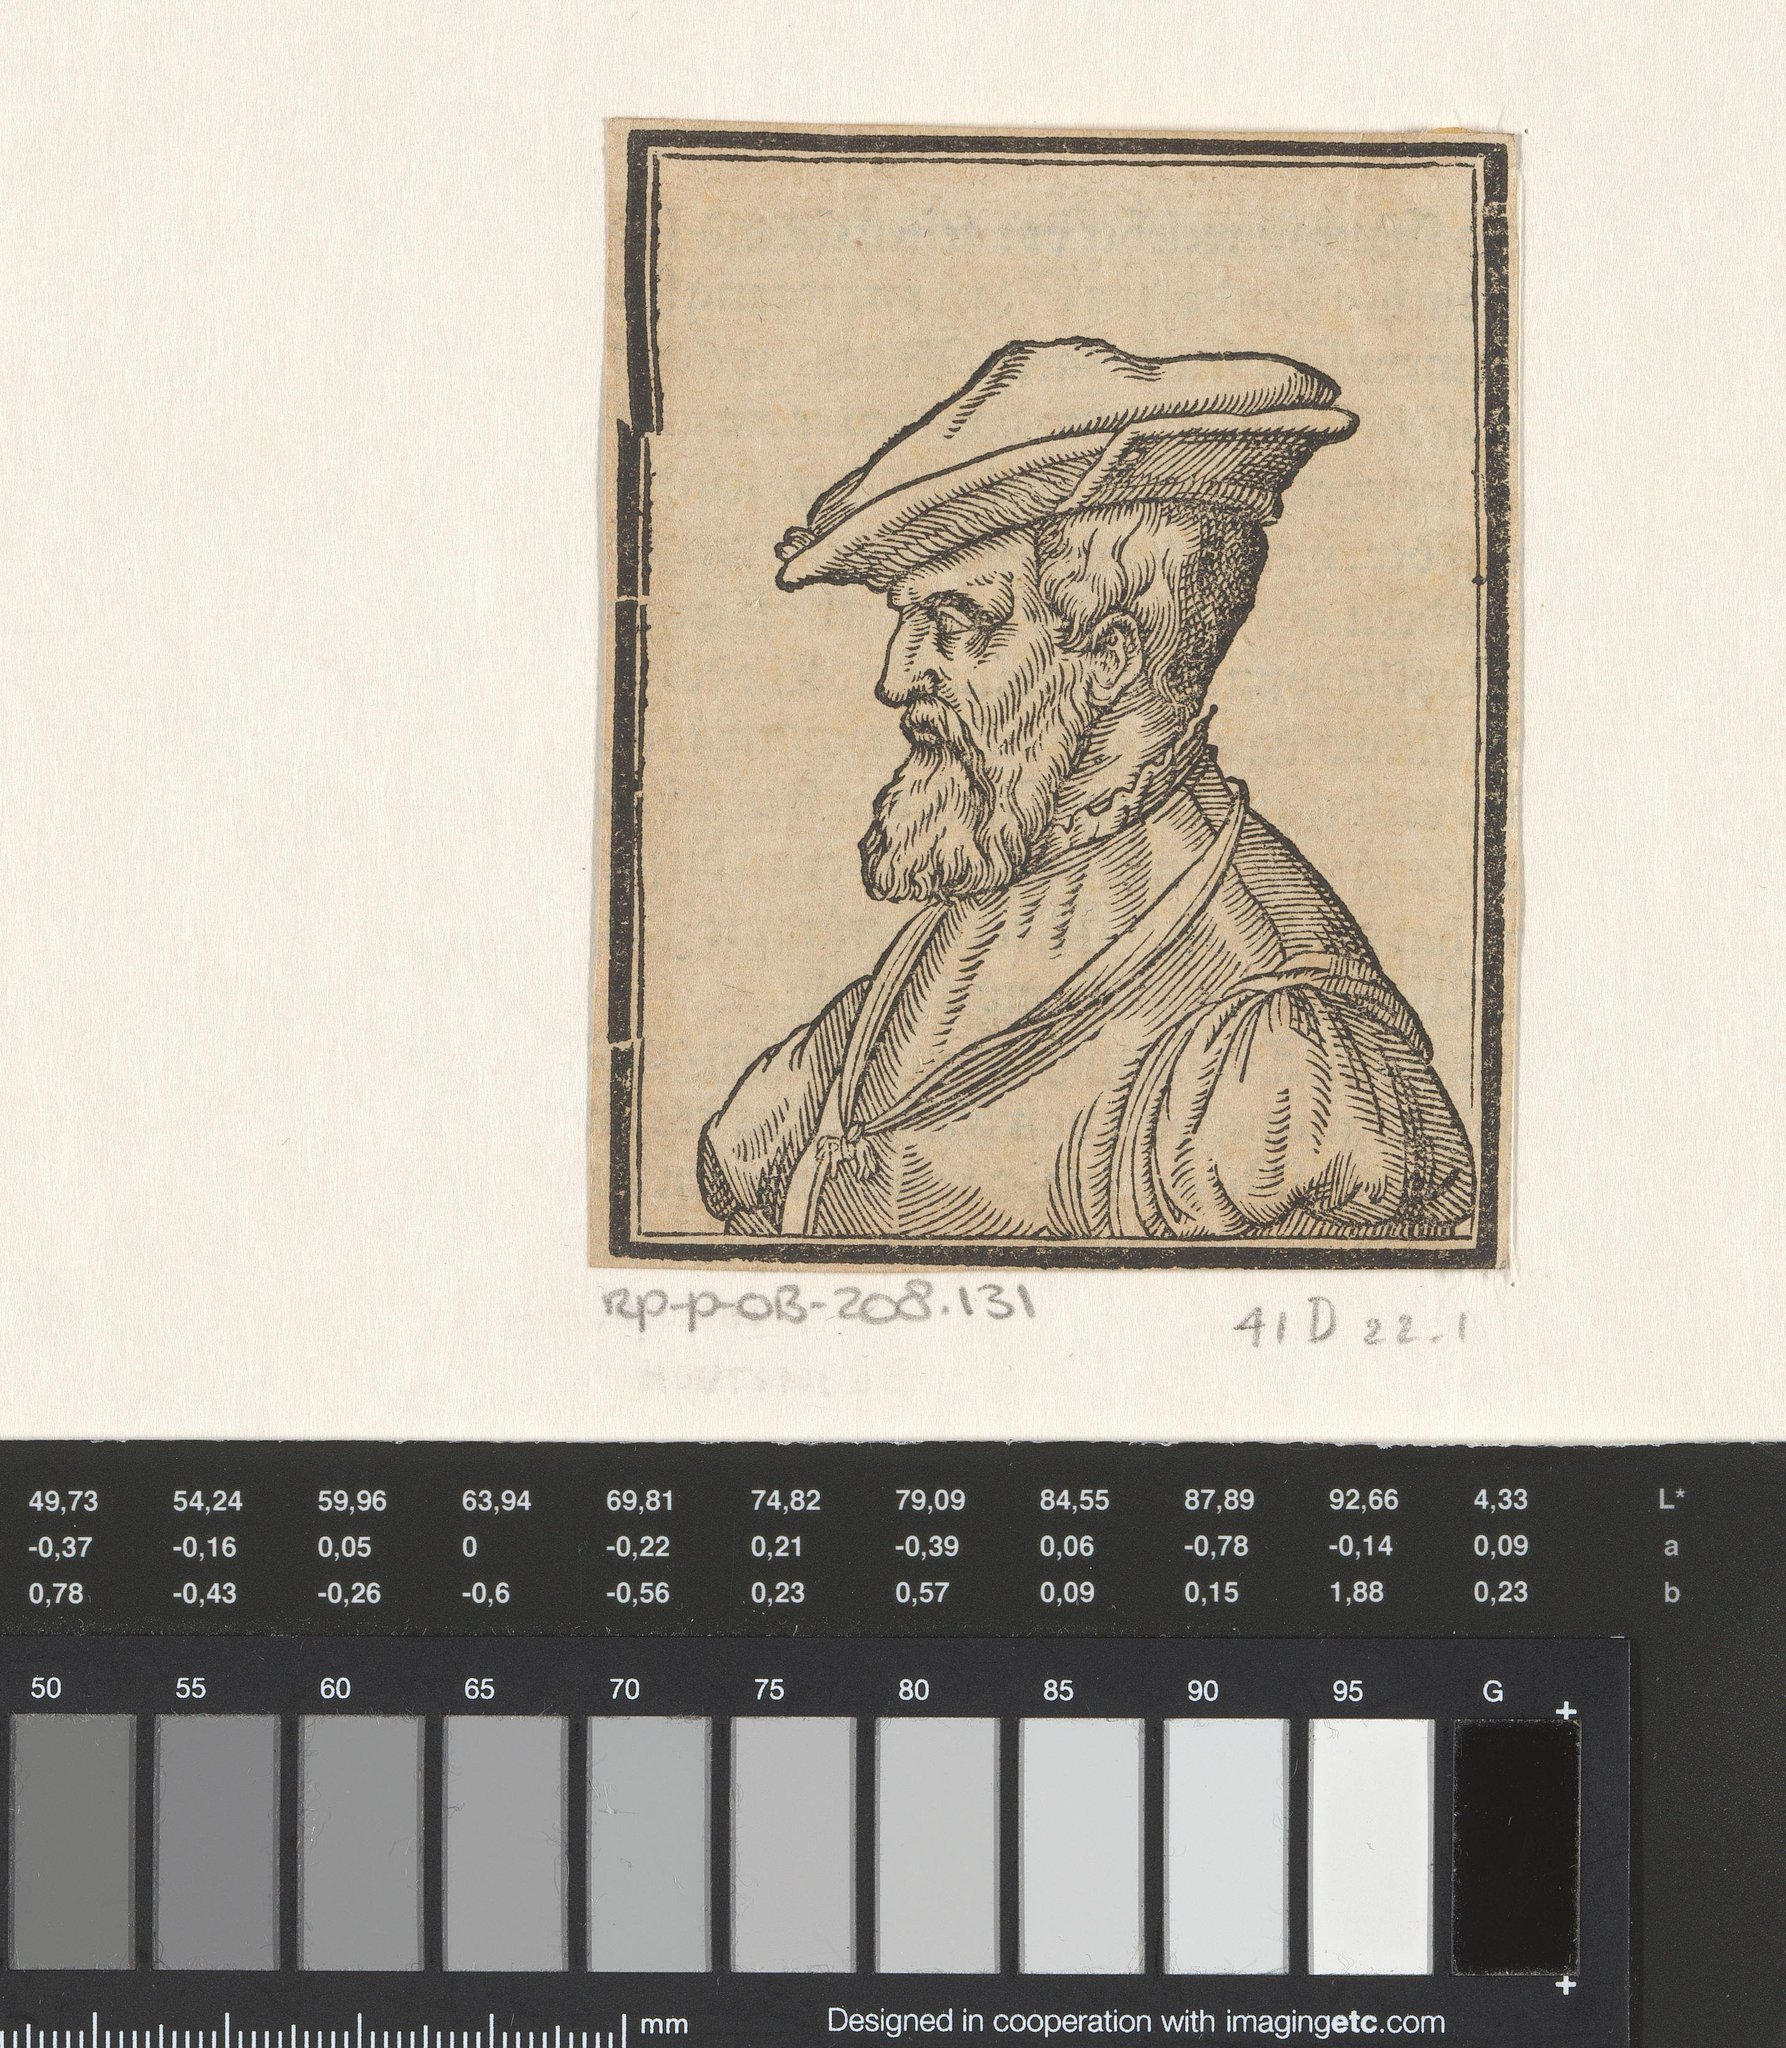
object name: print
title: Portret van een man met een hoed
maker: Anonymous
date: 1600-1699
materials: paper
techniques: letterpress printing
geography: germany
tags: head-gear, anonymous historical person portrayed alone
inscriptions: collector's mark: Lugt 2228